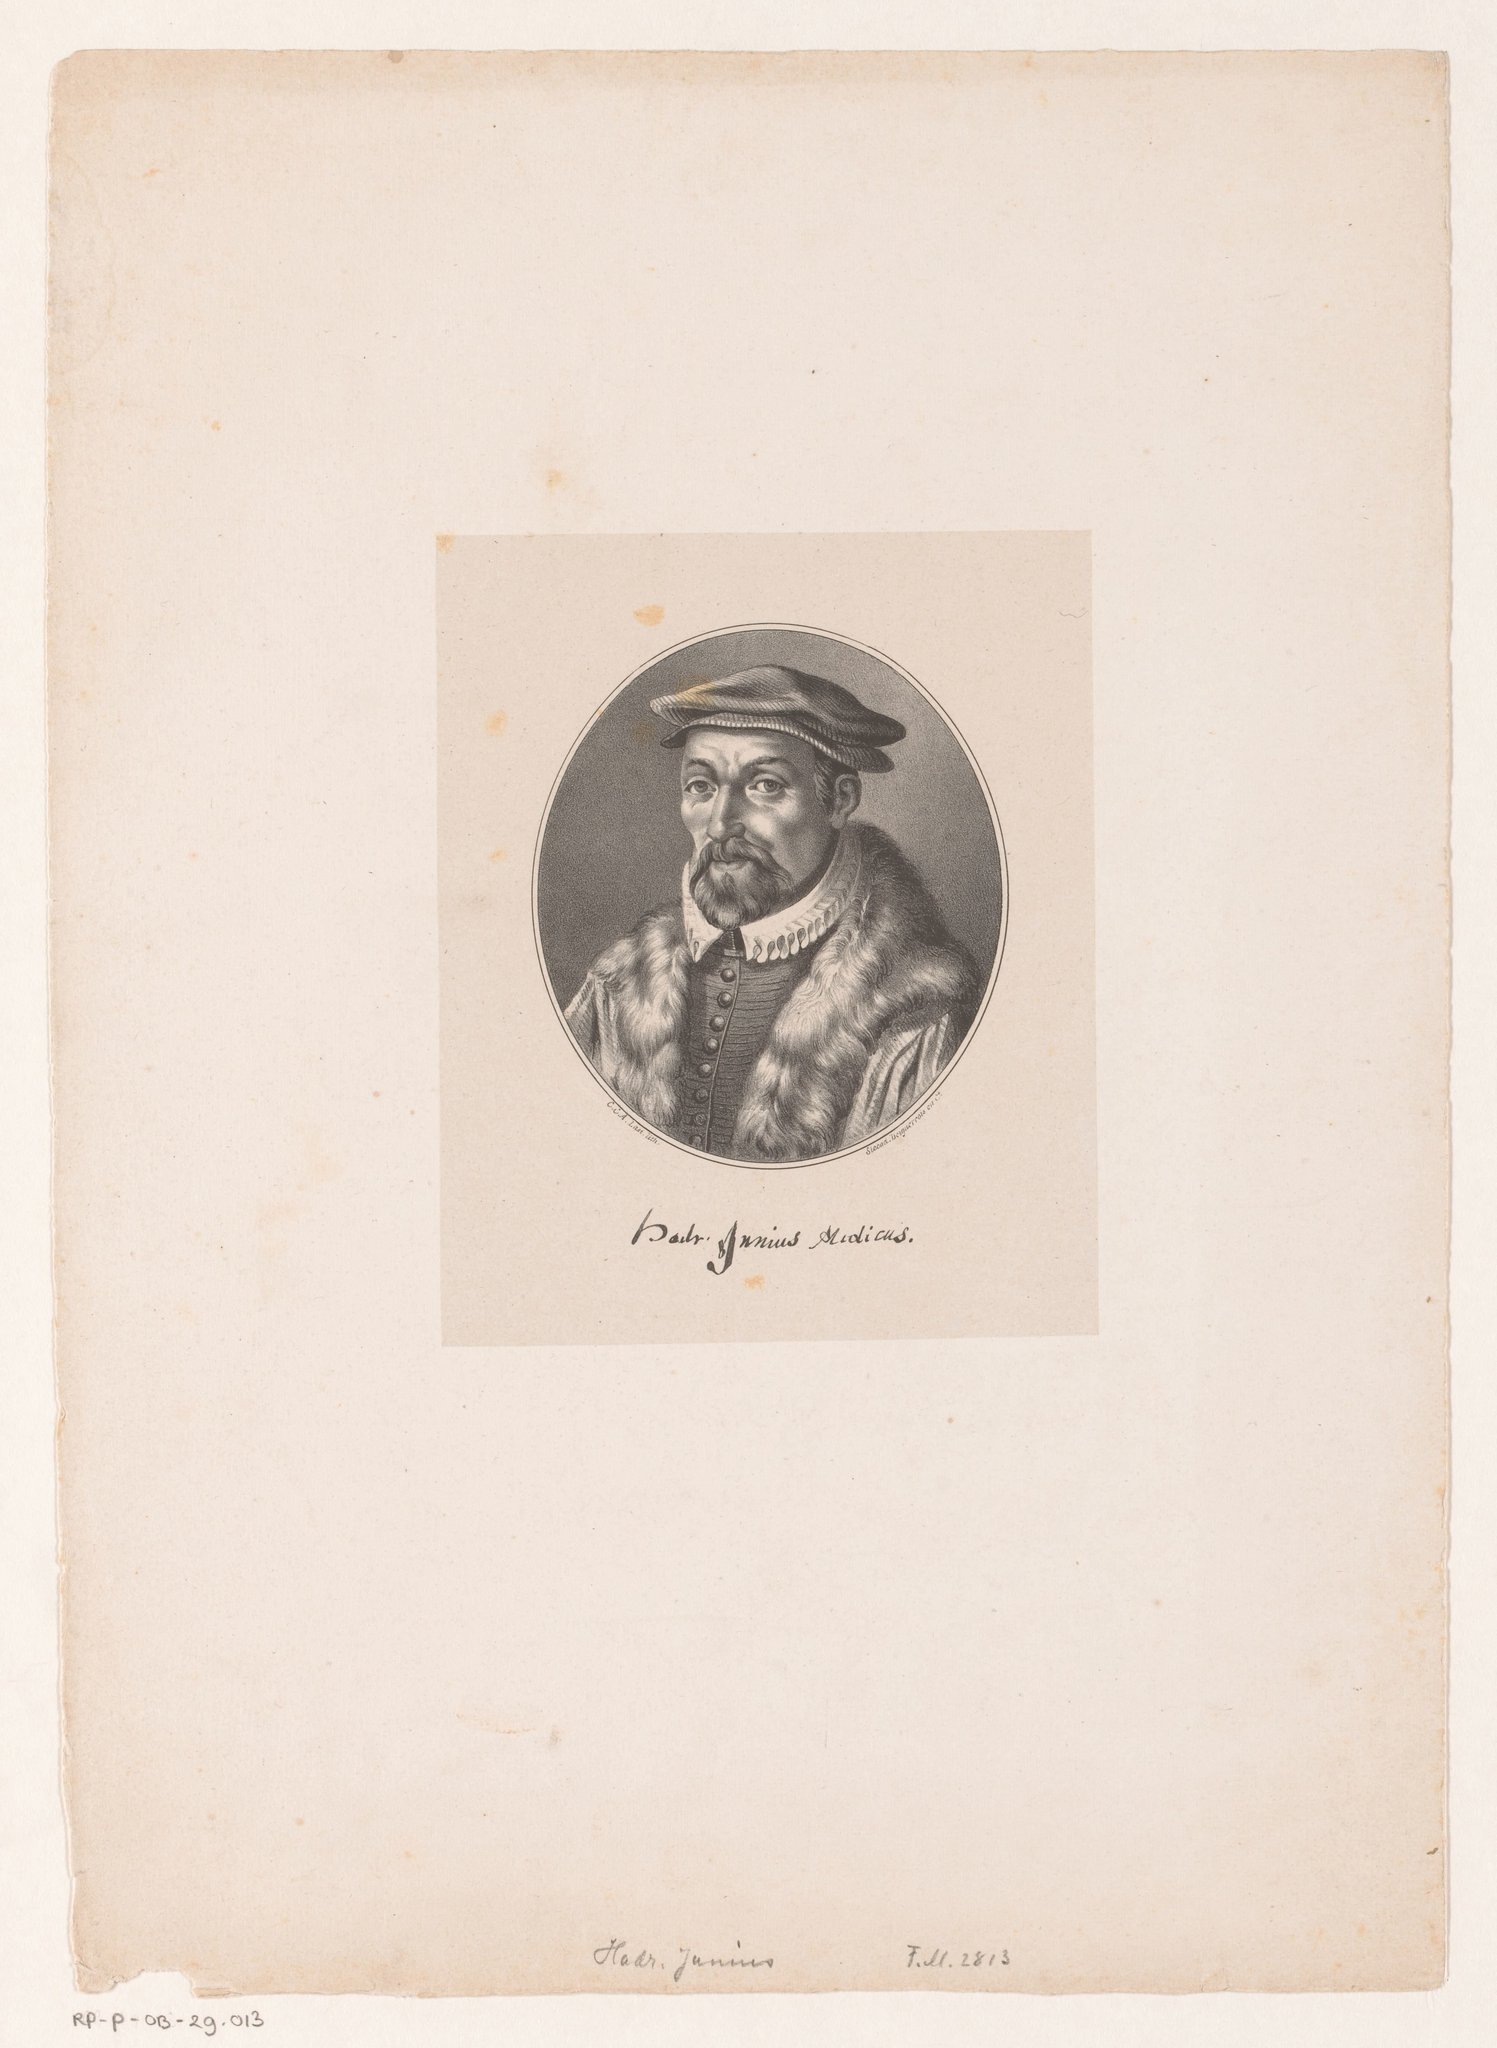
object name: print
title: Portret van Hadrianus Junius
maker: carel christiaan antony last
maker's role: print maker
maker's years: 1808-1876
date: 1818-1853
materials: paper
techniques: lithograph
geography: netherlands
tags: hoorn (north holland), middelburg, hadrianus junius, historical persons (+ (full) bust portrait)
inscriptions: collector's mark: Lugt 2228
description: De geportretteerde draagt een mantel met bontkraag en een platte hoed. Onder het portret zijn naam.